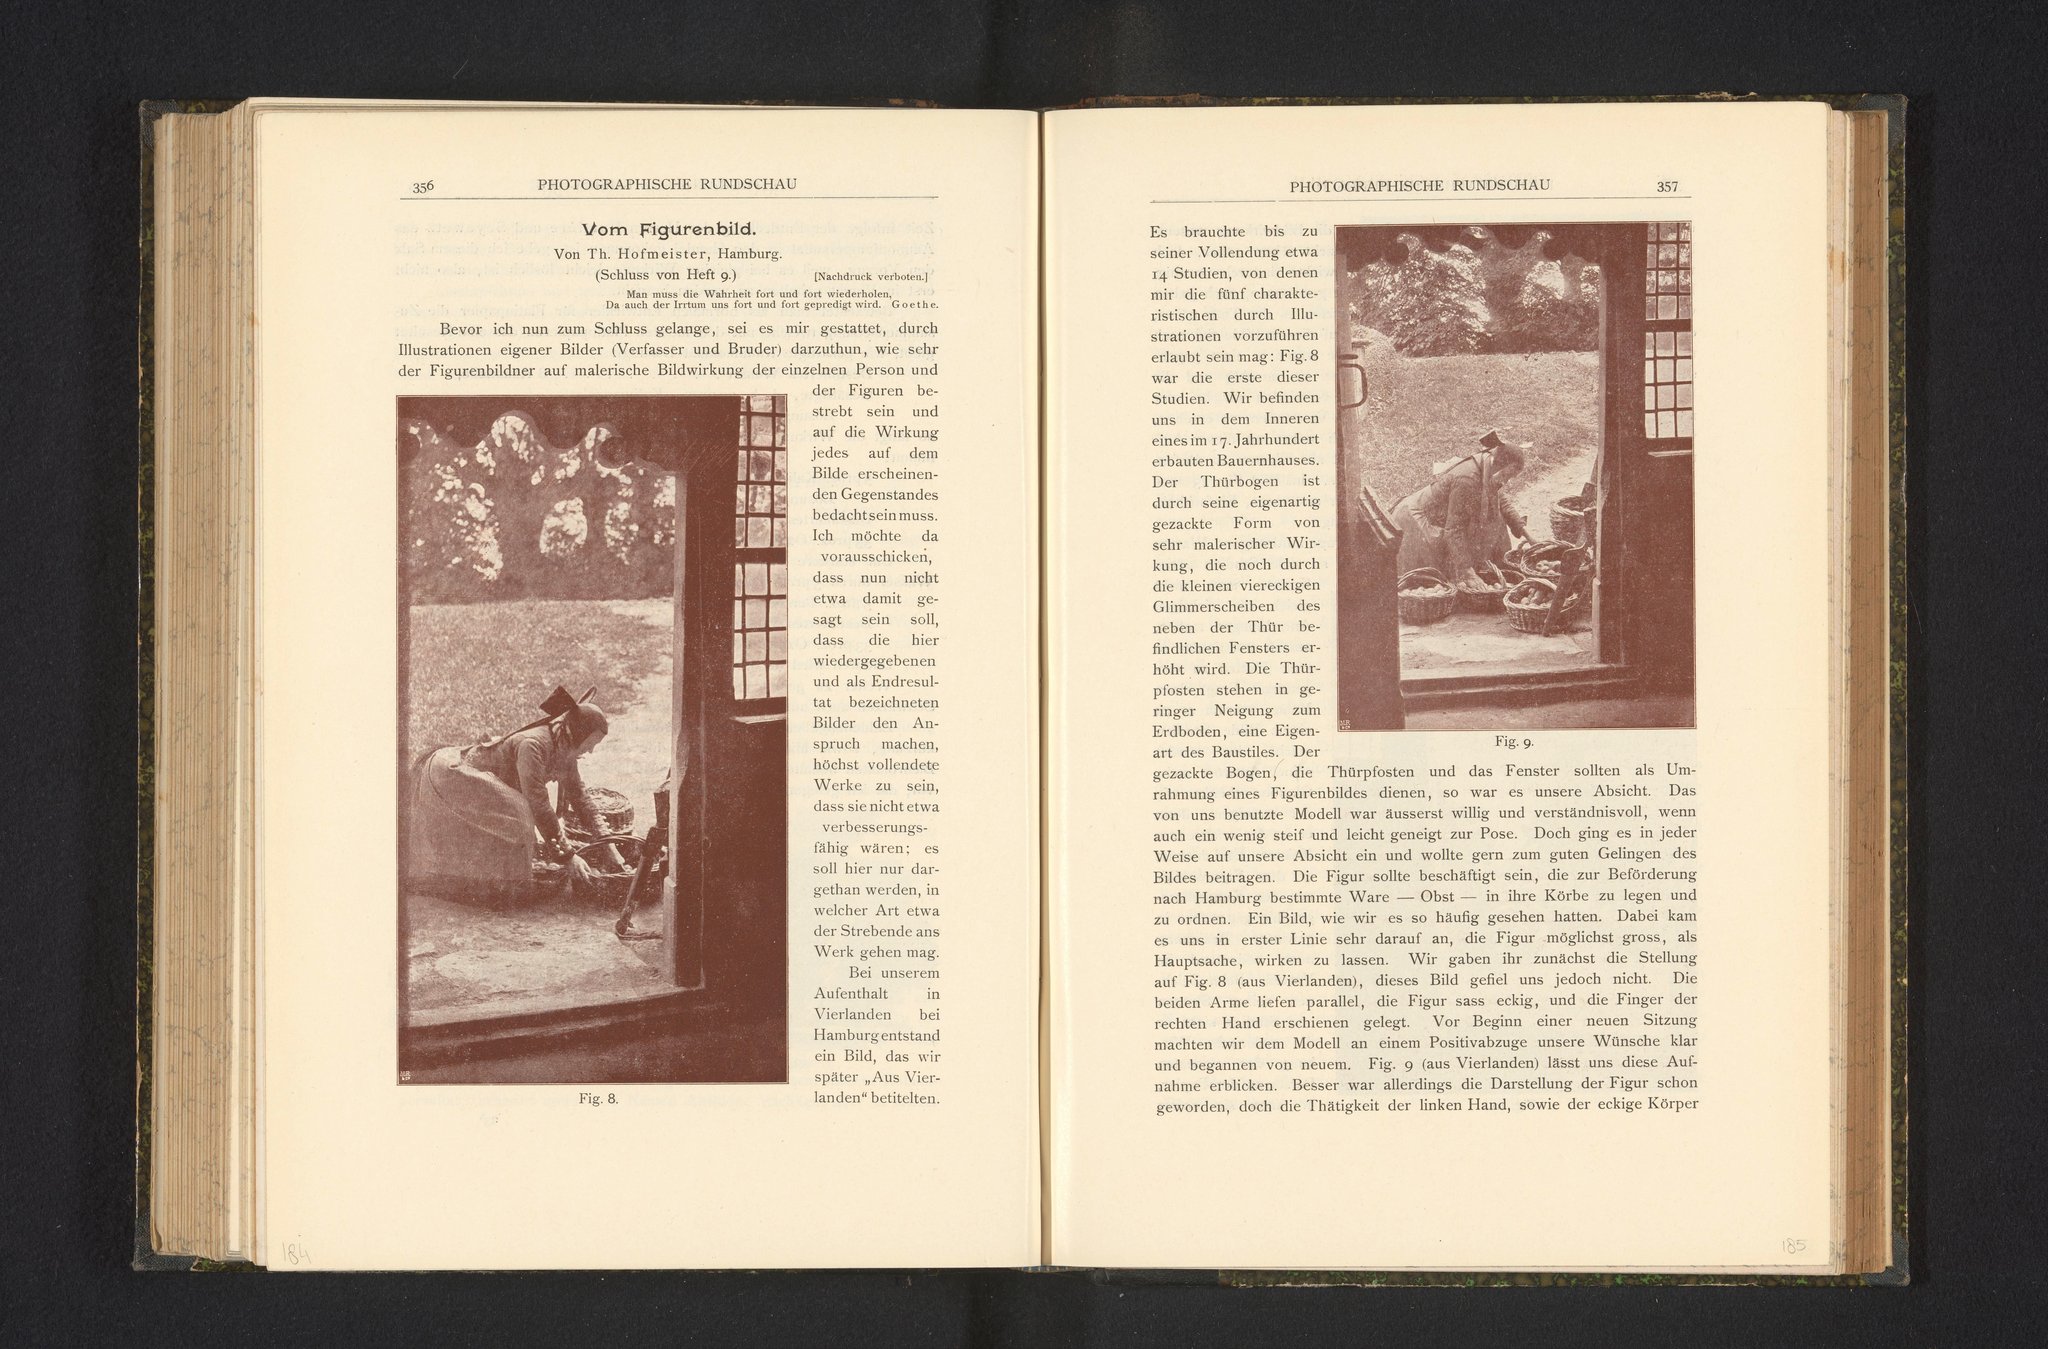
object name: page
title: Gezicht op een open deur waardoor een onbekende vrouw te zien is die buiten zit bij manden met groenten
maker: Anonymous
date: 1893-1898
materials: paper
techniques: autotype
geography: berlin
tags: adult woman, open door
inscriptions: monogram: ‘MR/ &Co’